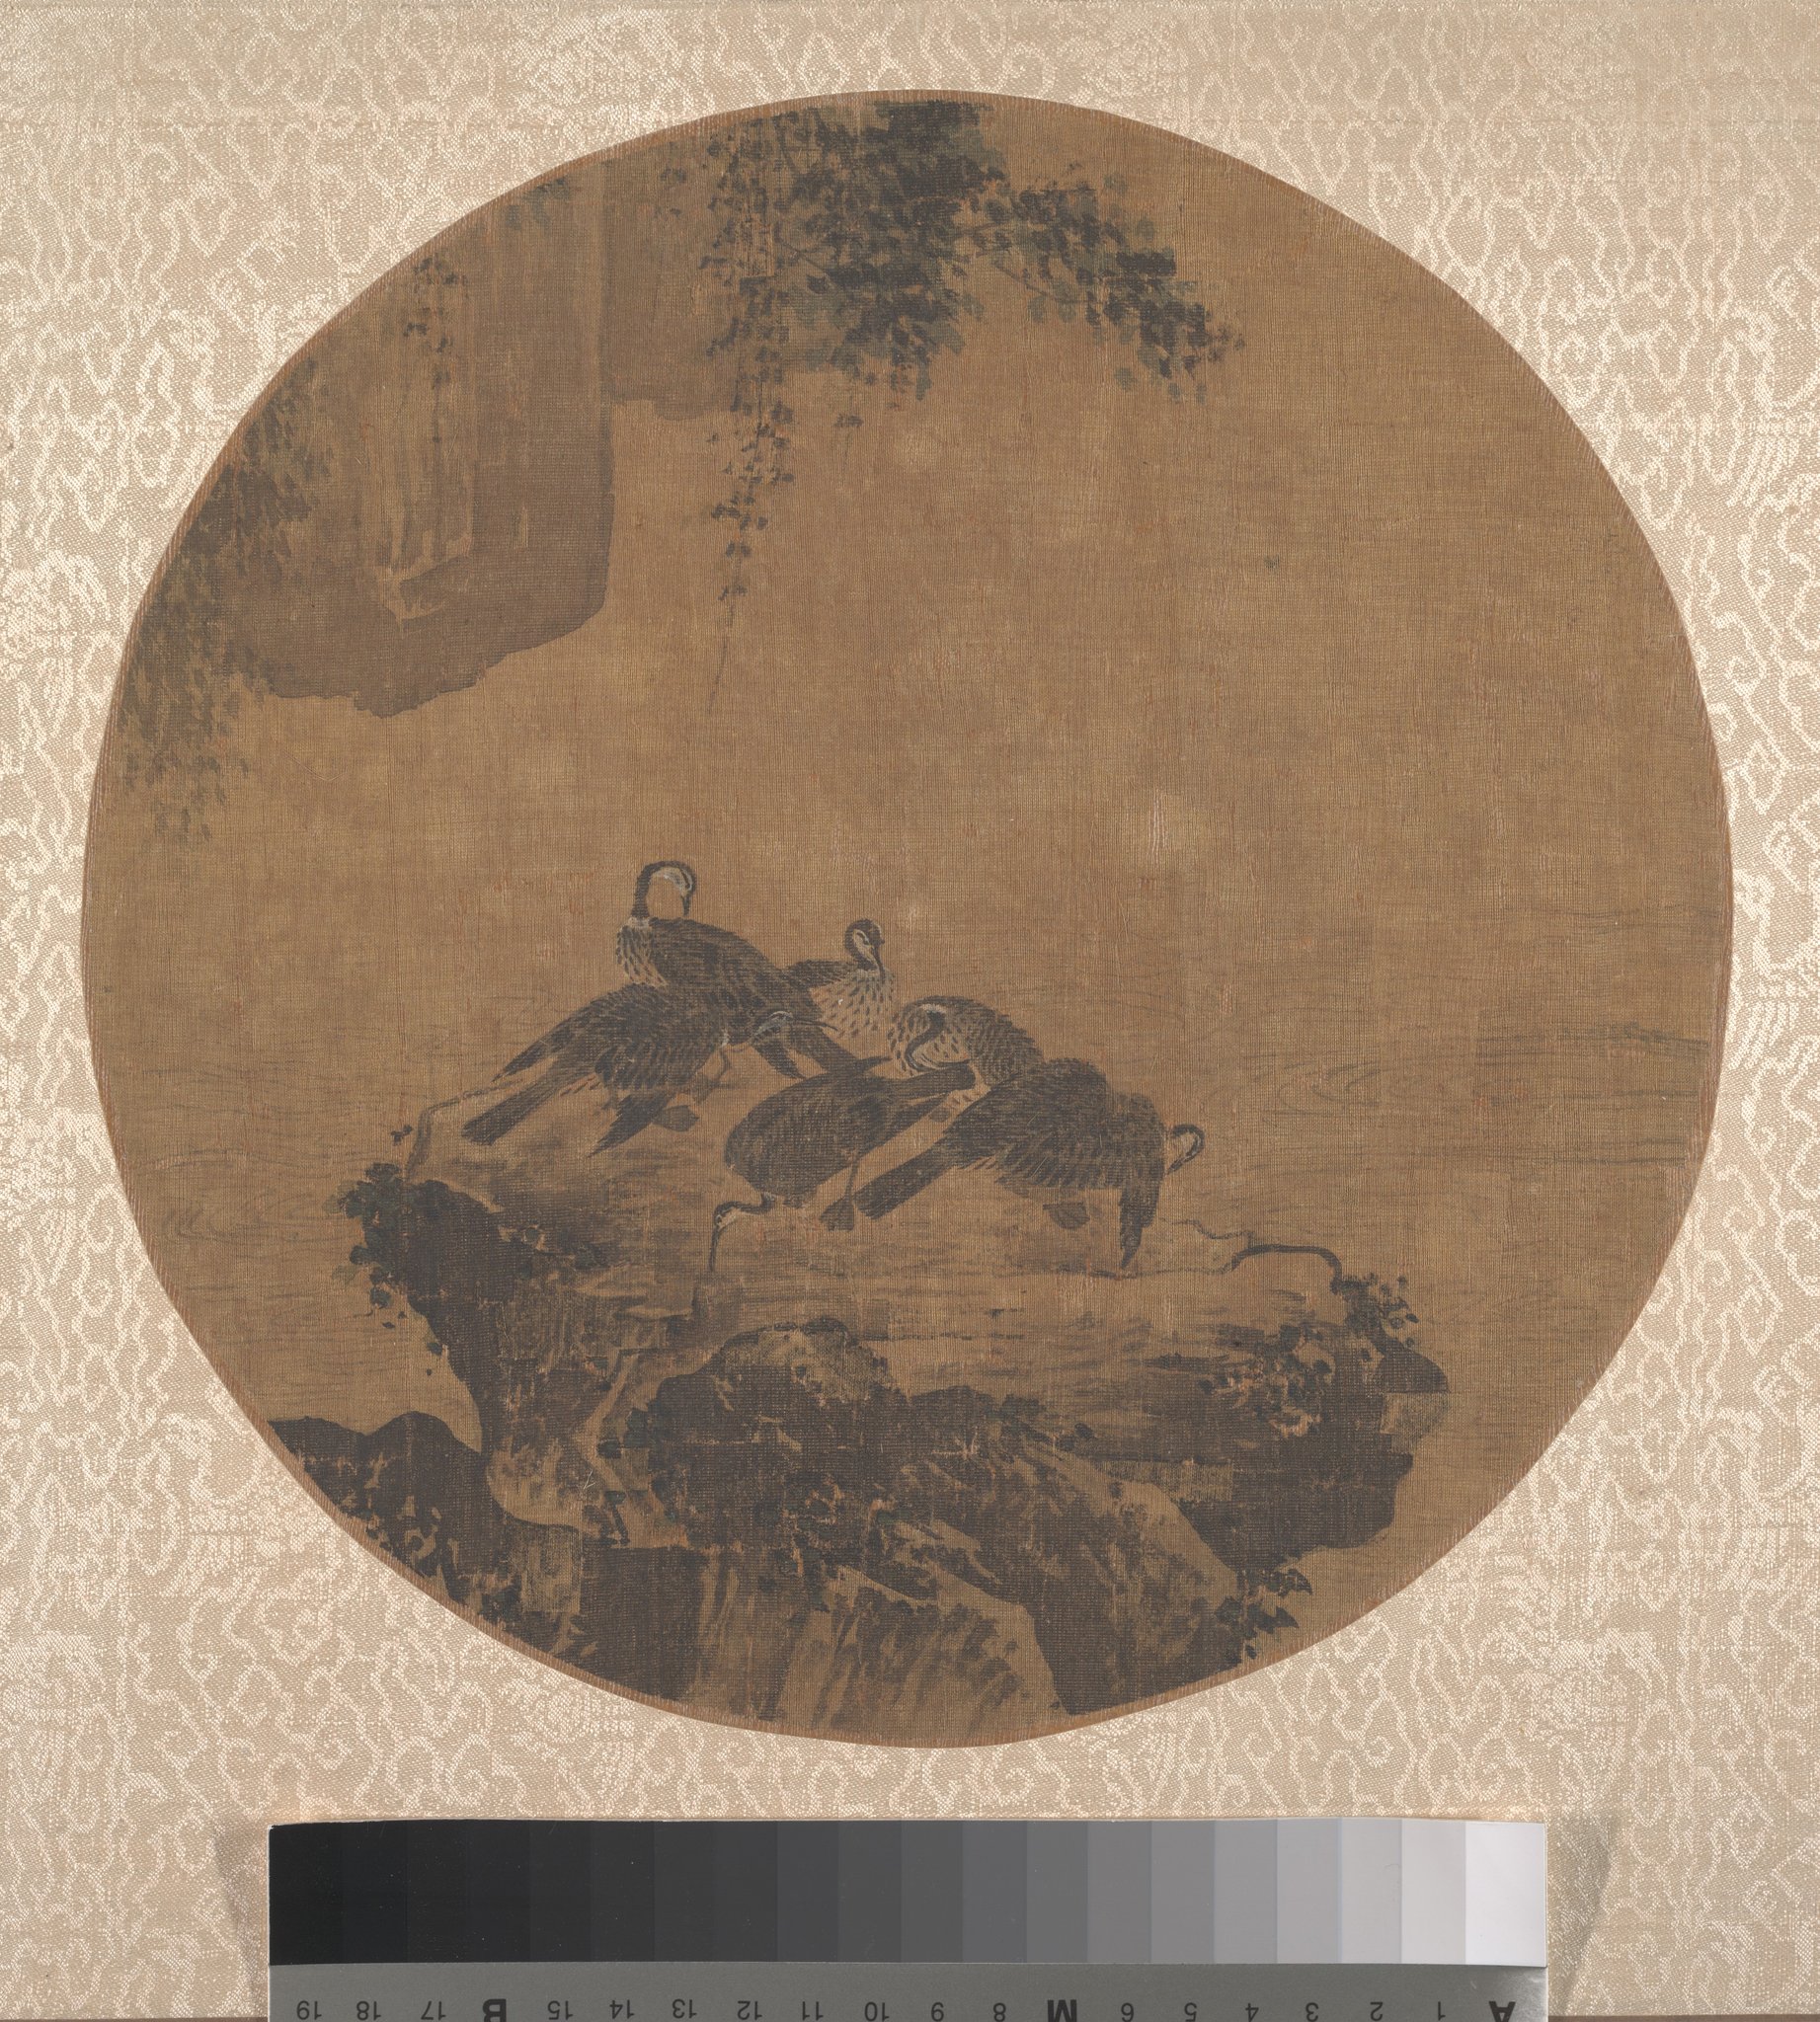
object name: fan mounted a an album leaf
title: Cormorants on Rock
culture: chinese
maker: unidentified artist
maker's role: artist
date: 1368-1644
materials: ink, silk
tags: birds